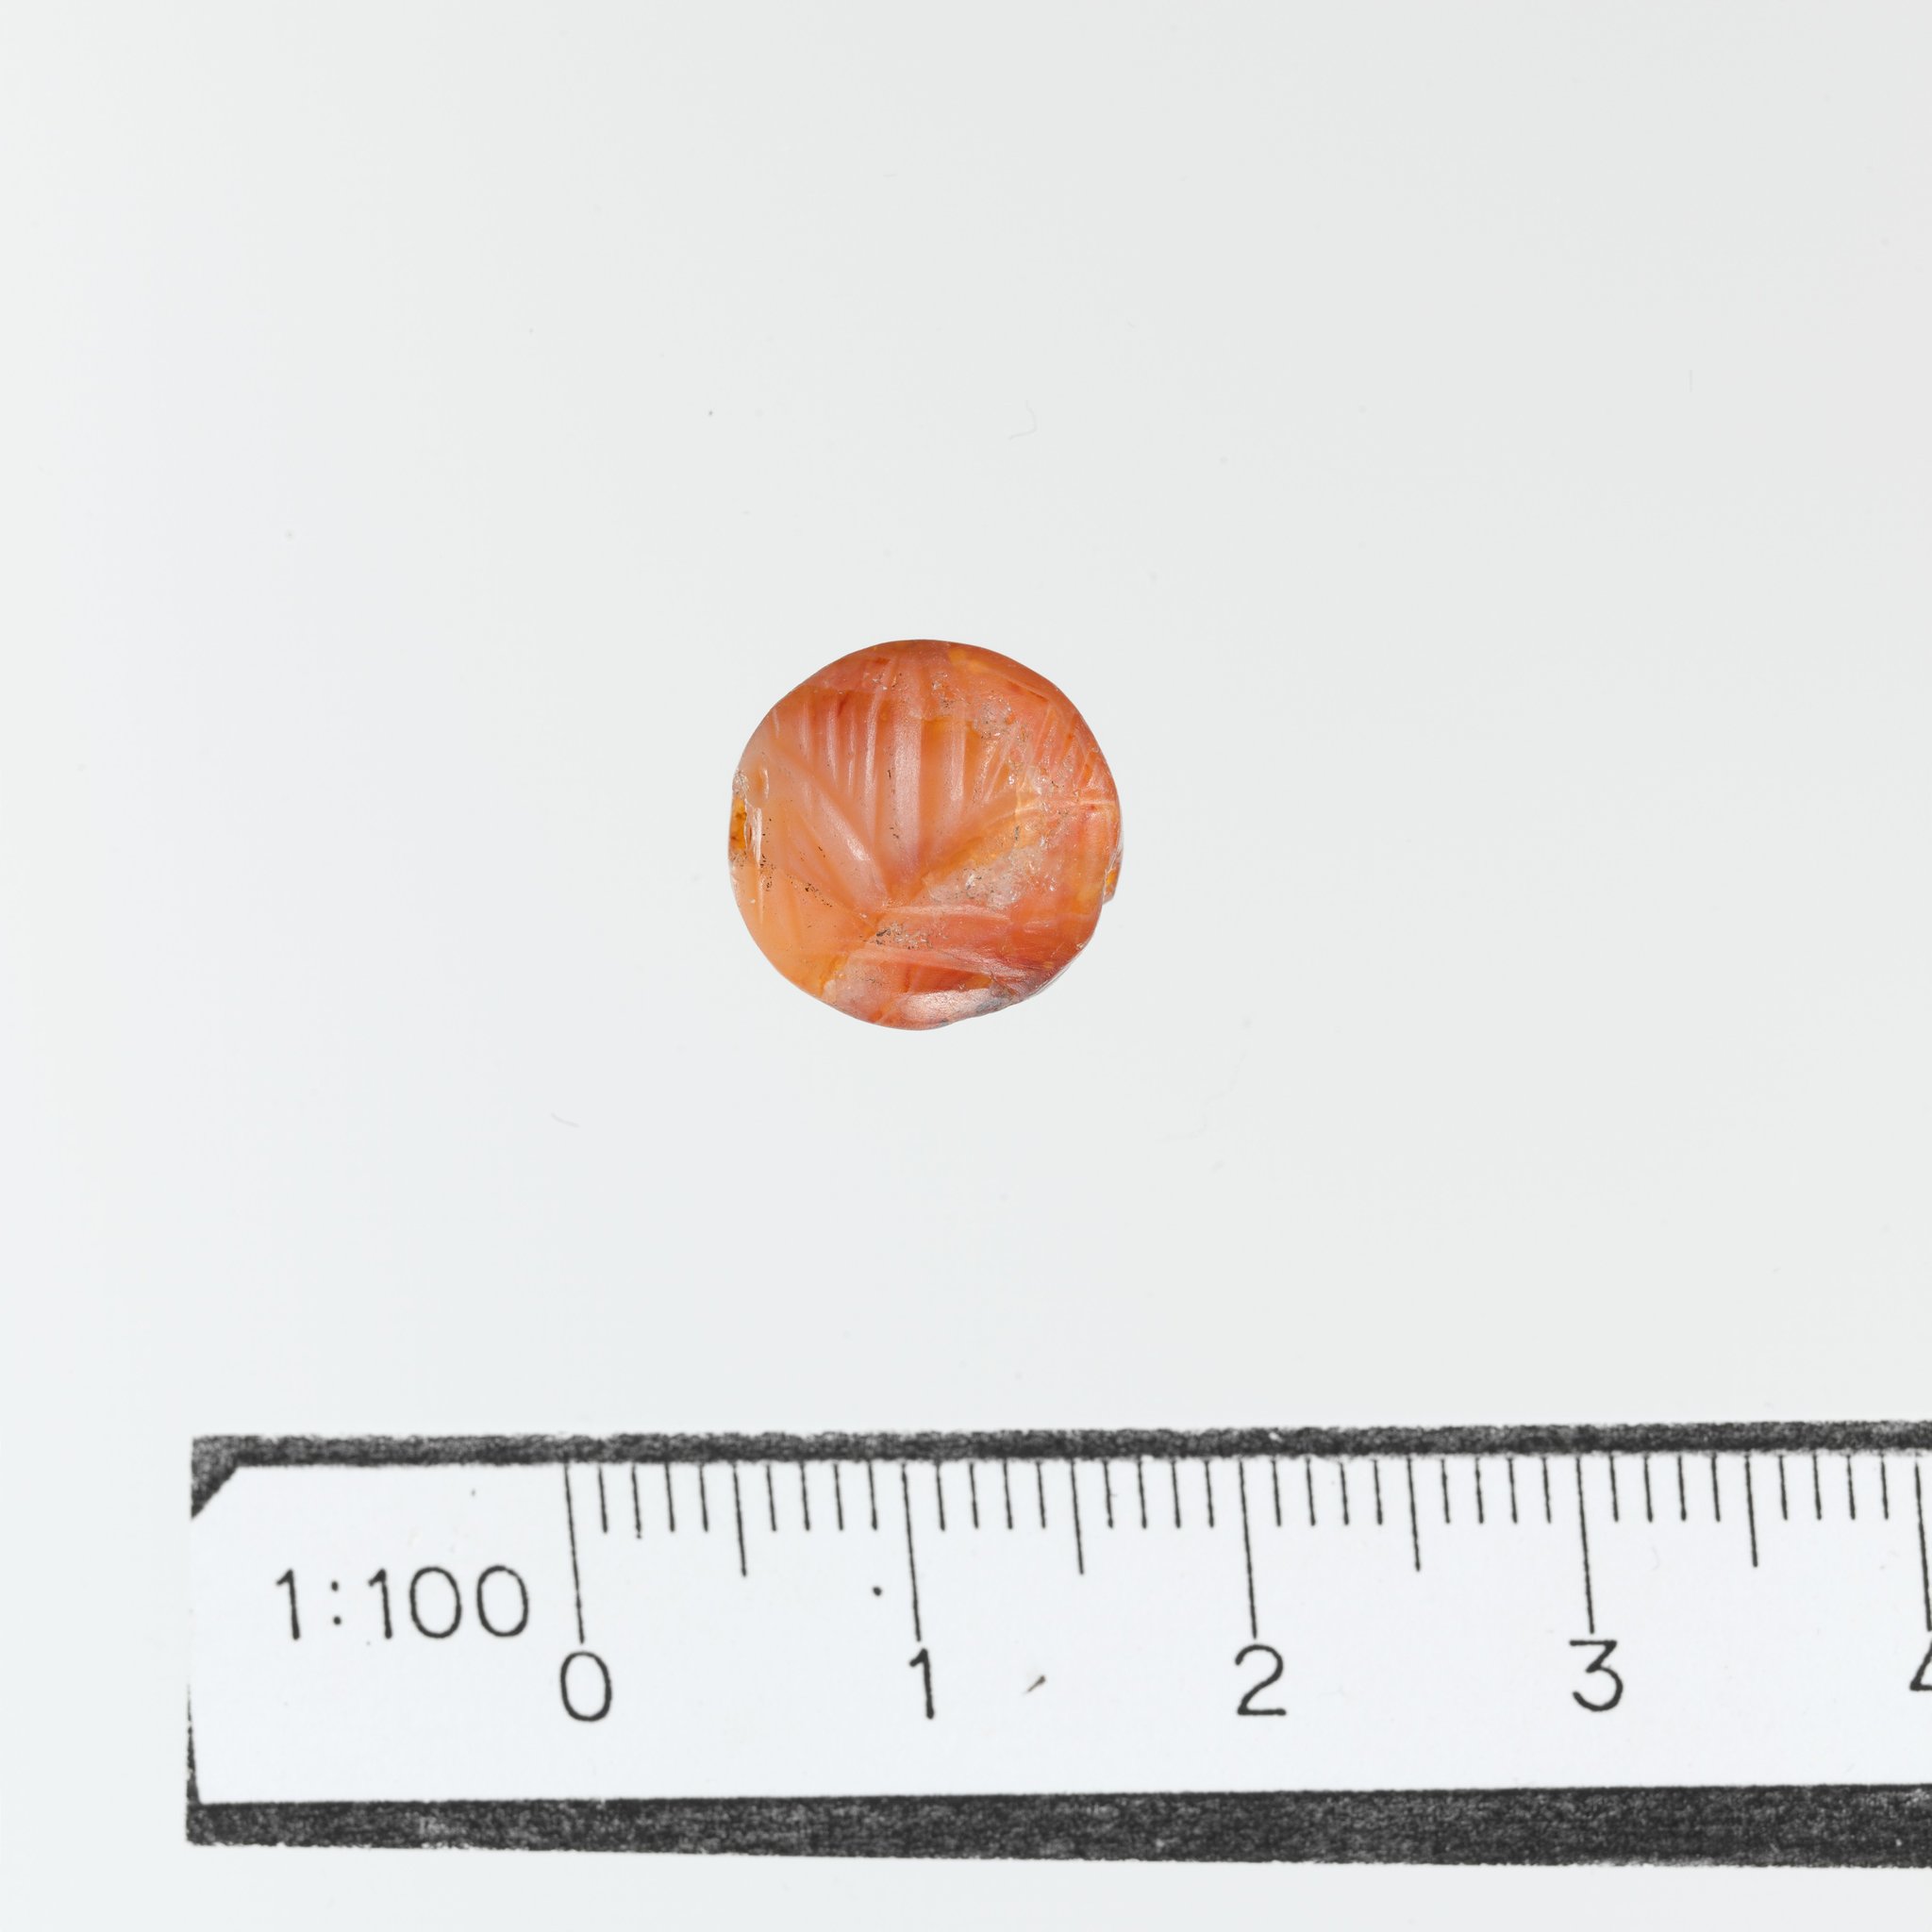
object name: seal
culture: minoan, crete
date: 2000-1450 BCE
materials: gemstone